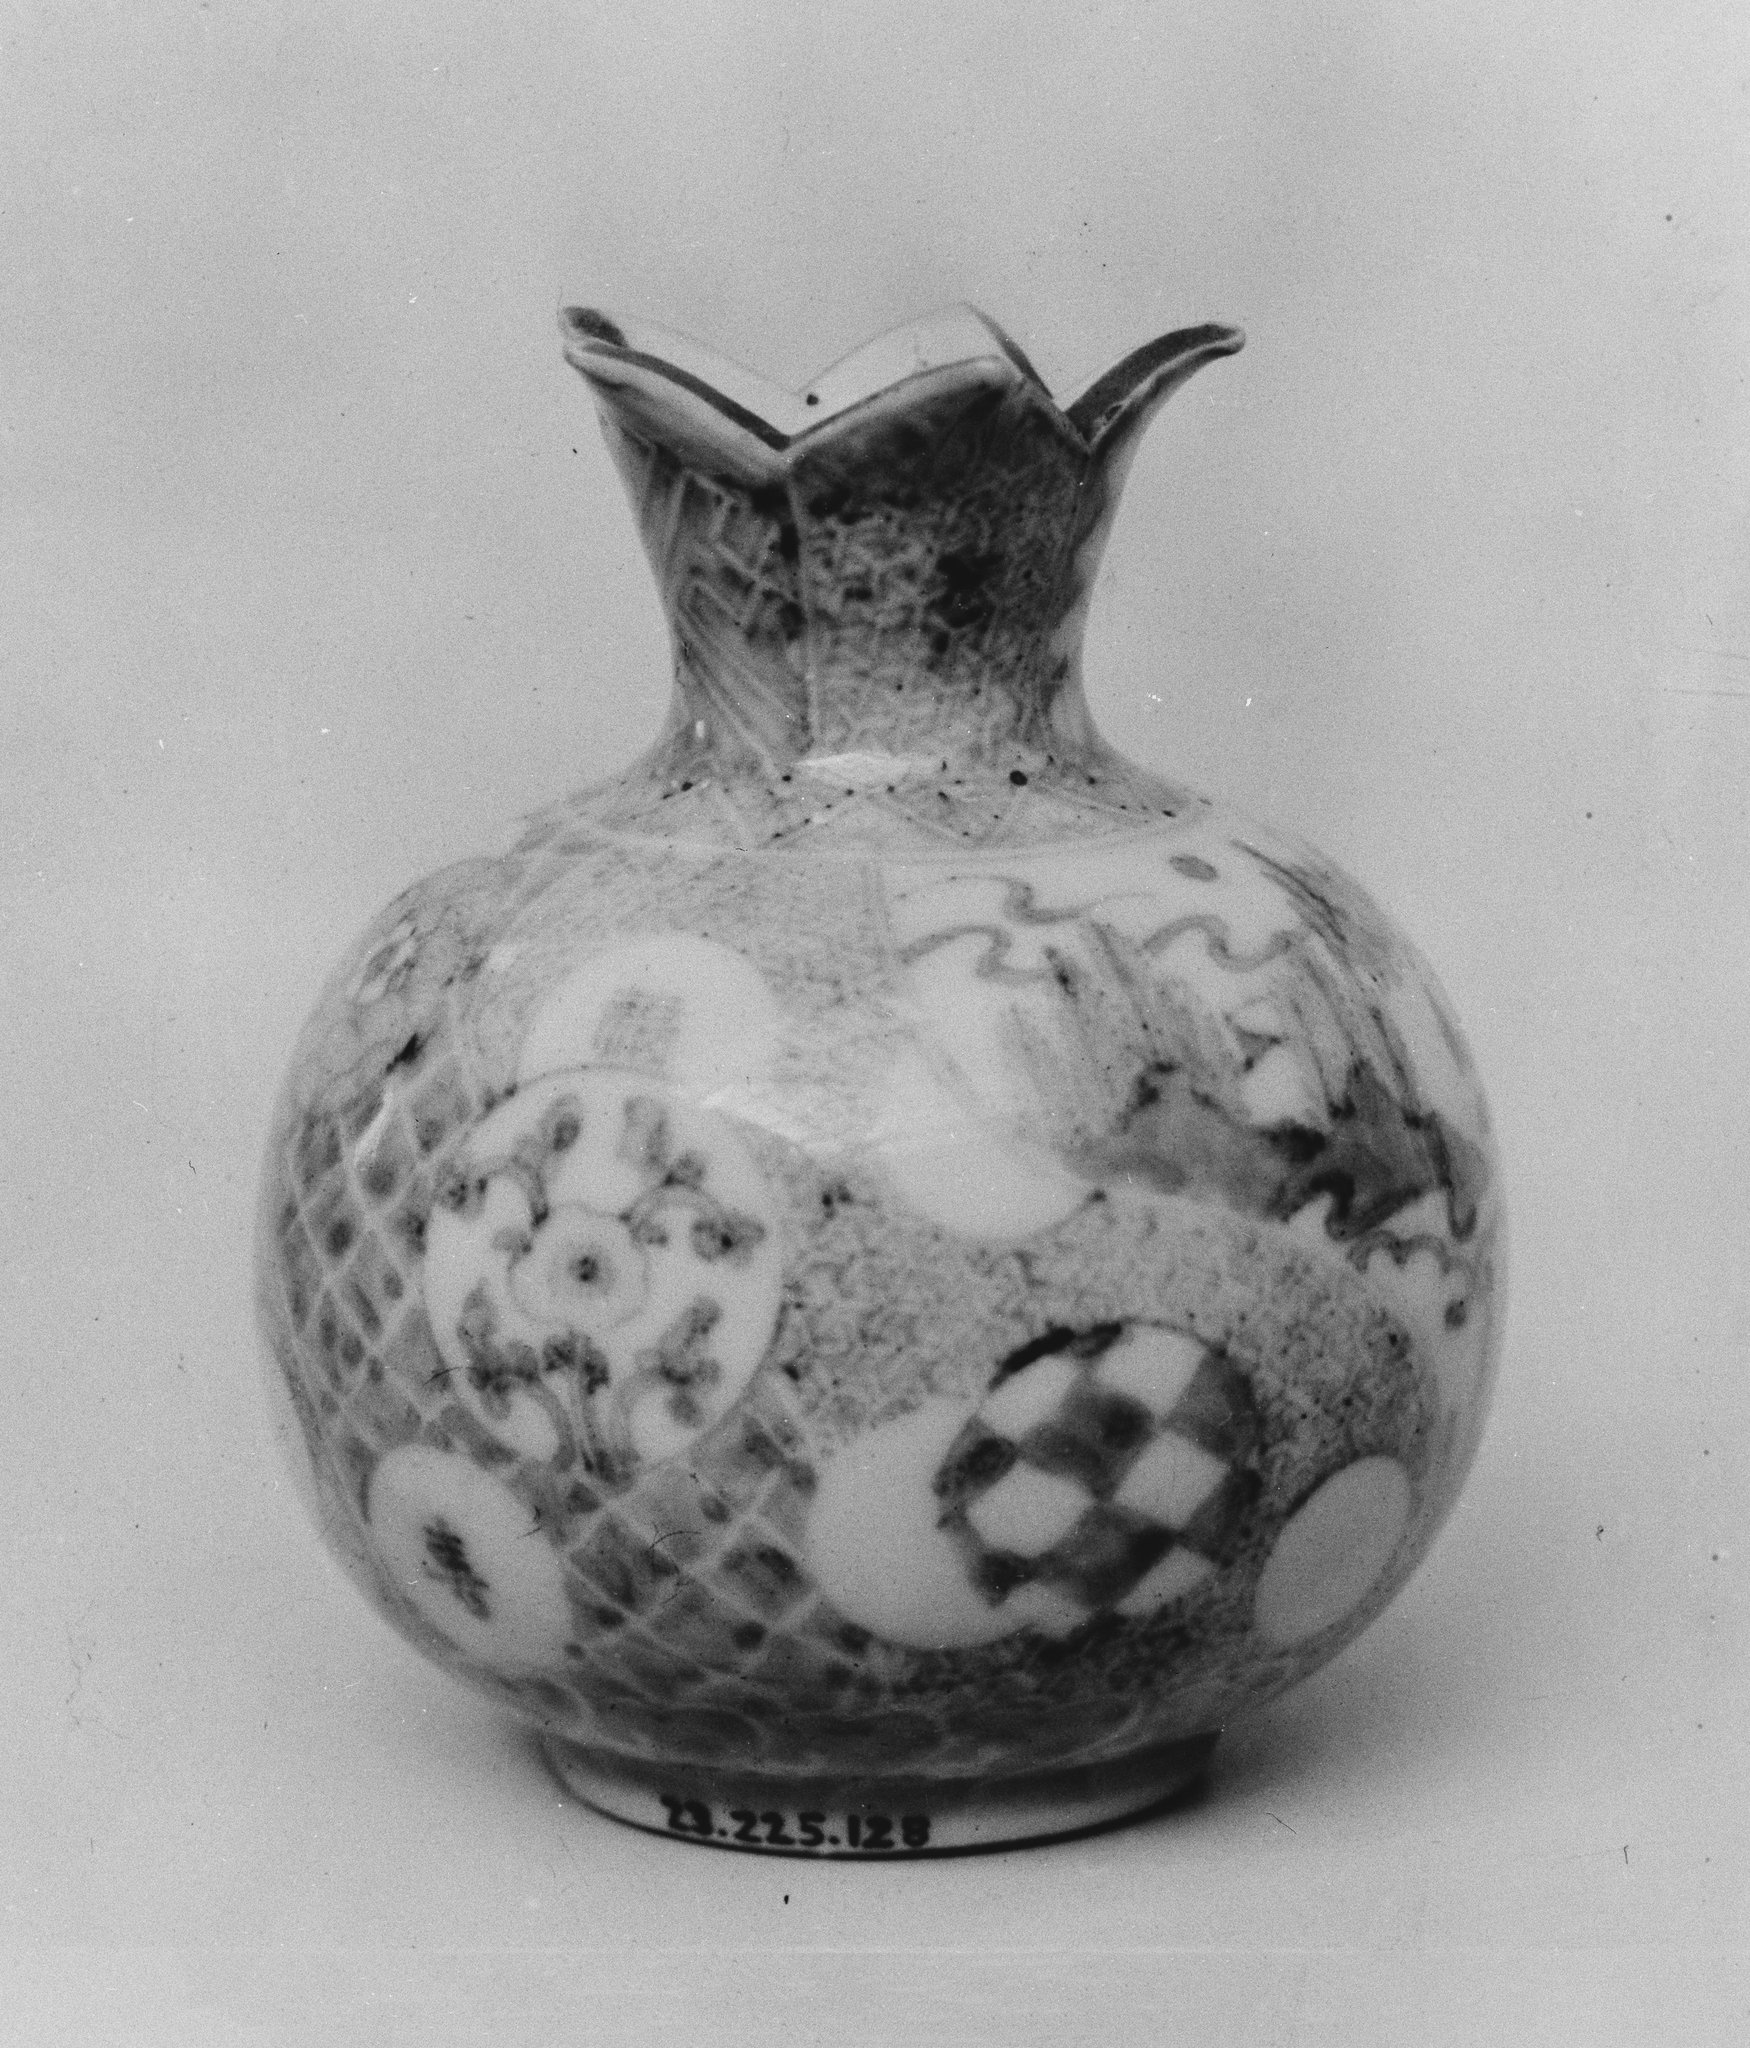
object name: bottle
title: Bonbon Bottle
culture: japanese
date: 1750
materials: glaze, porcelain